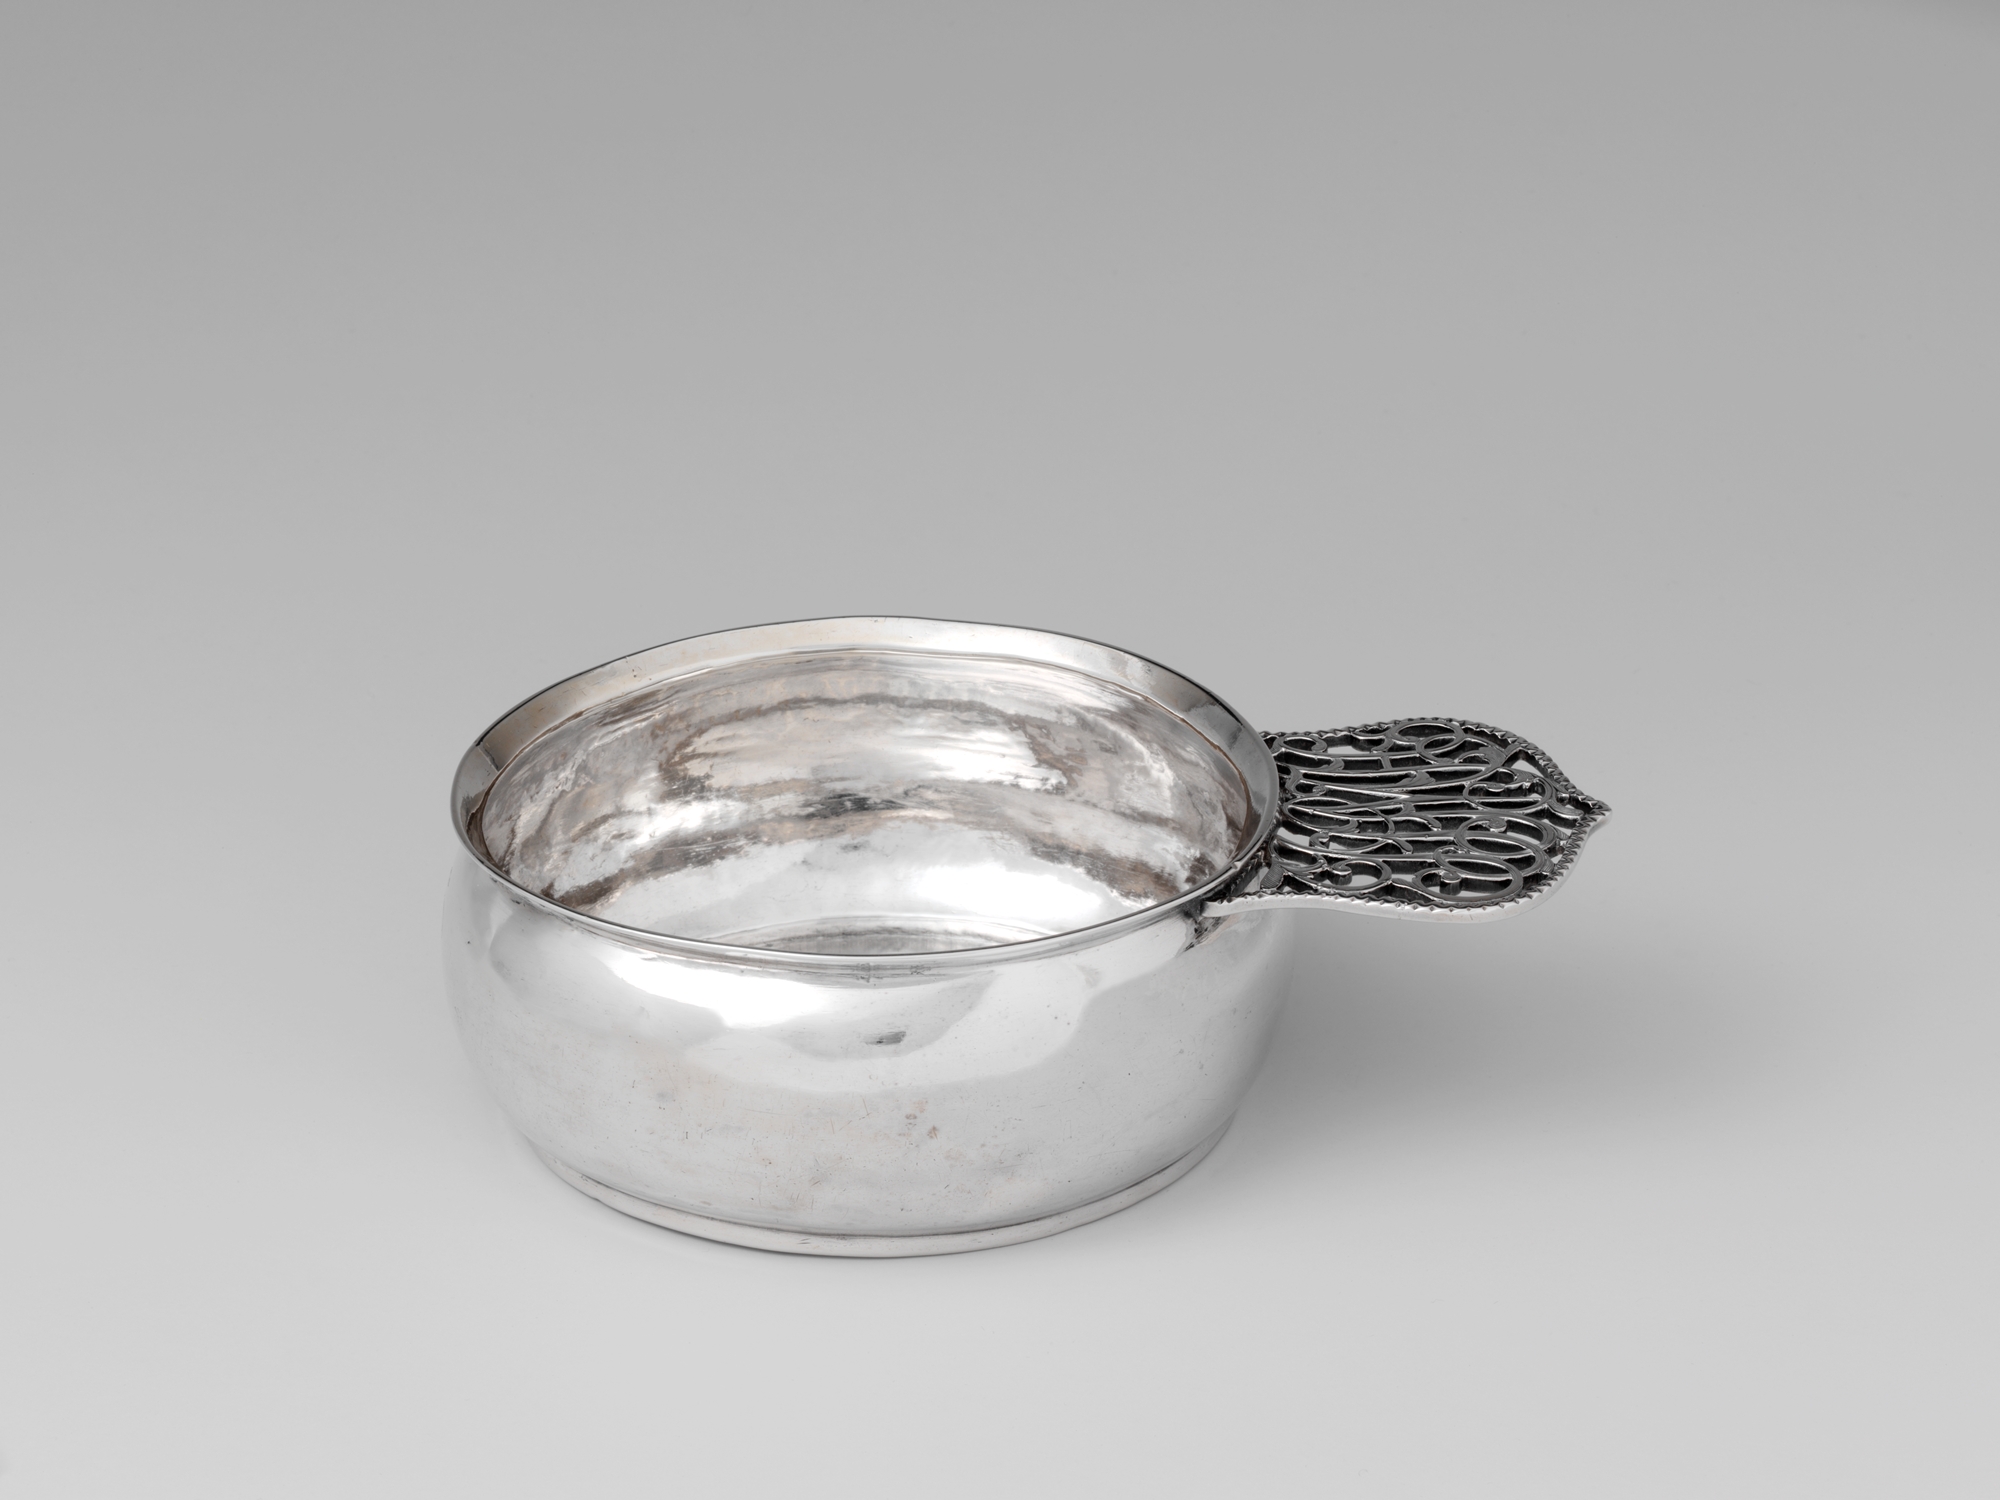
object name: porringer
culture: american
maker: andrew billings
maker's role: maker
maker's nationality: american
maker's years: 1743-1808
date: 1785-1805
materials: silver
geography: united states